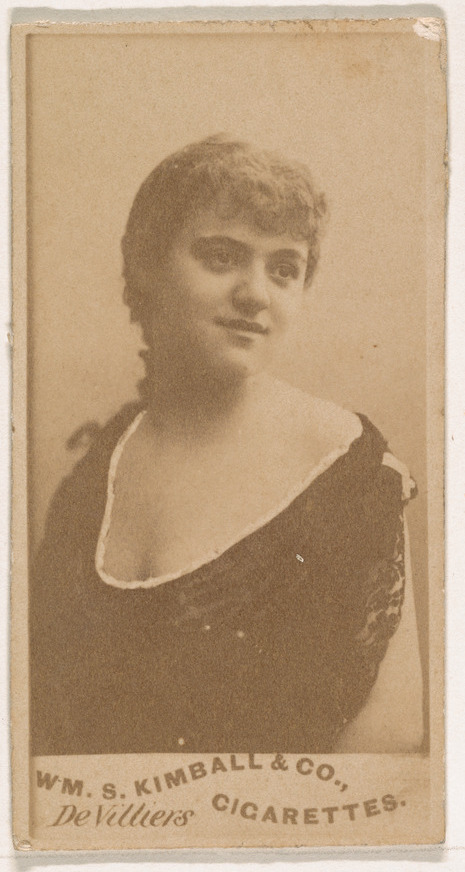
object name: photograph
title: Miss De Villiers, from the Actresses series (N203) issued by Wm. S. Kimball & Co.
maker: william s. kimball & company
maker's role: publisher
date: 1889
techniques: color lithograph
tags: portraits,women,actresses